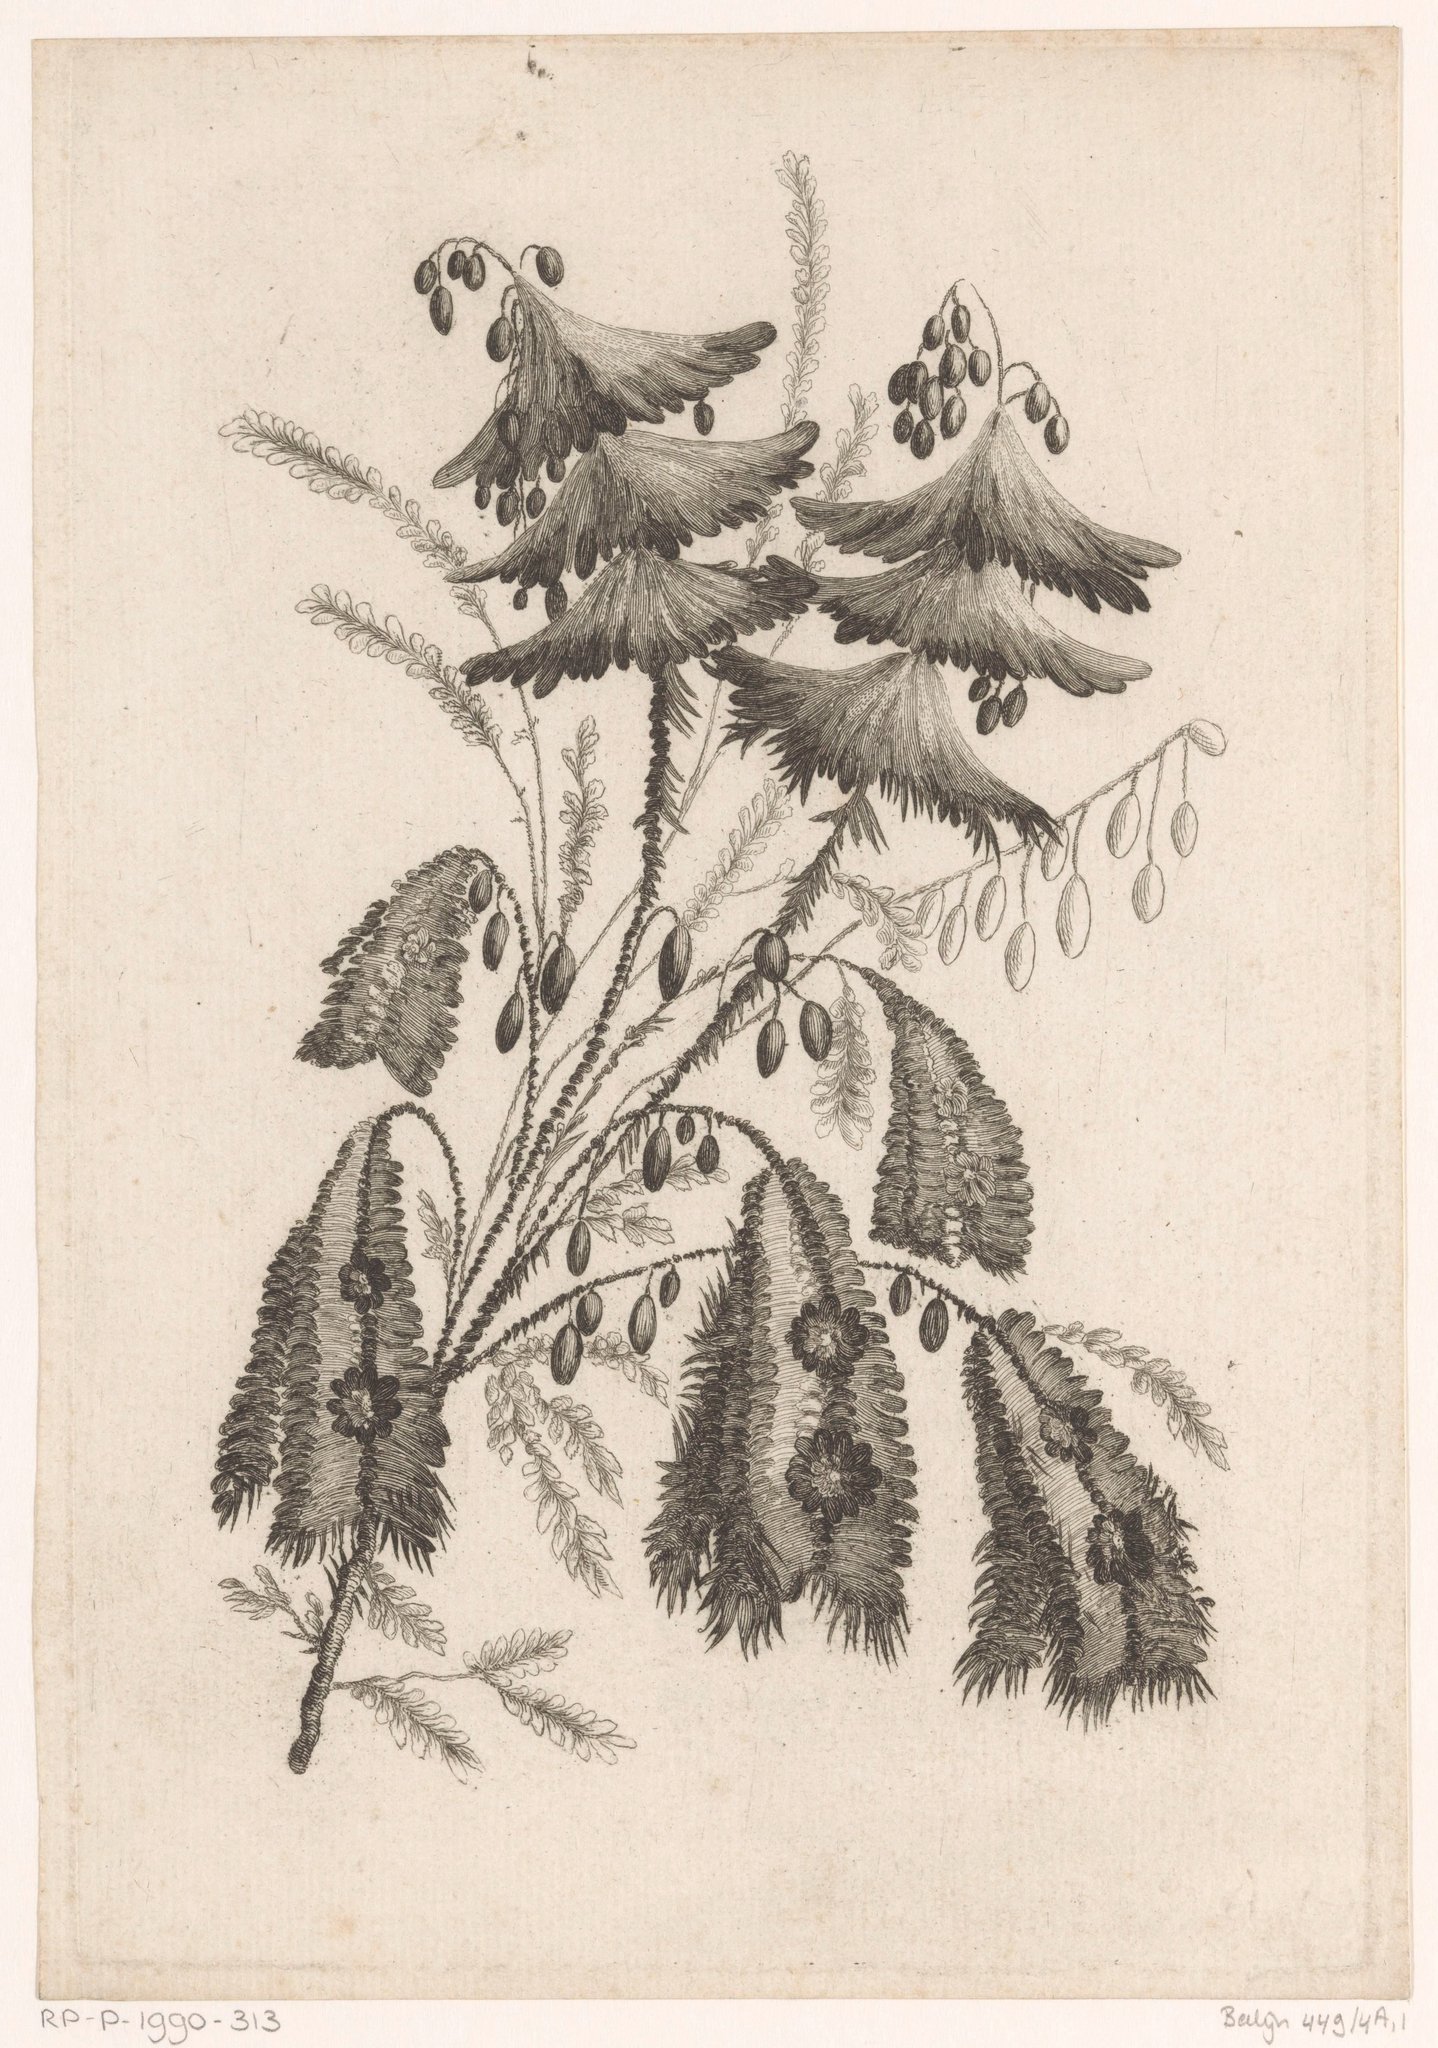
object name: print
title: Parasolachtige bloemen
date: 1755-1775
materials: paper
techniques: etching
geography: paris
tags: flowers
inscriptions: collector's mark: Lugt 2760, collector's mark: Lugt 2228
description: Driehoekige bloemen en aan de bovenzijde drie parasolachtige bloemen met bessen boven elkaar.